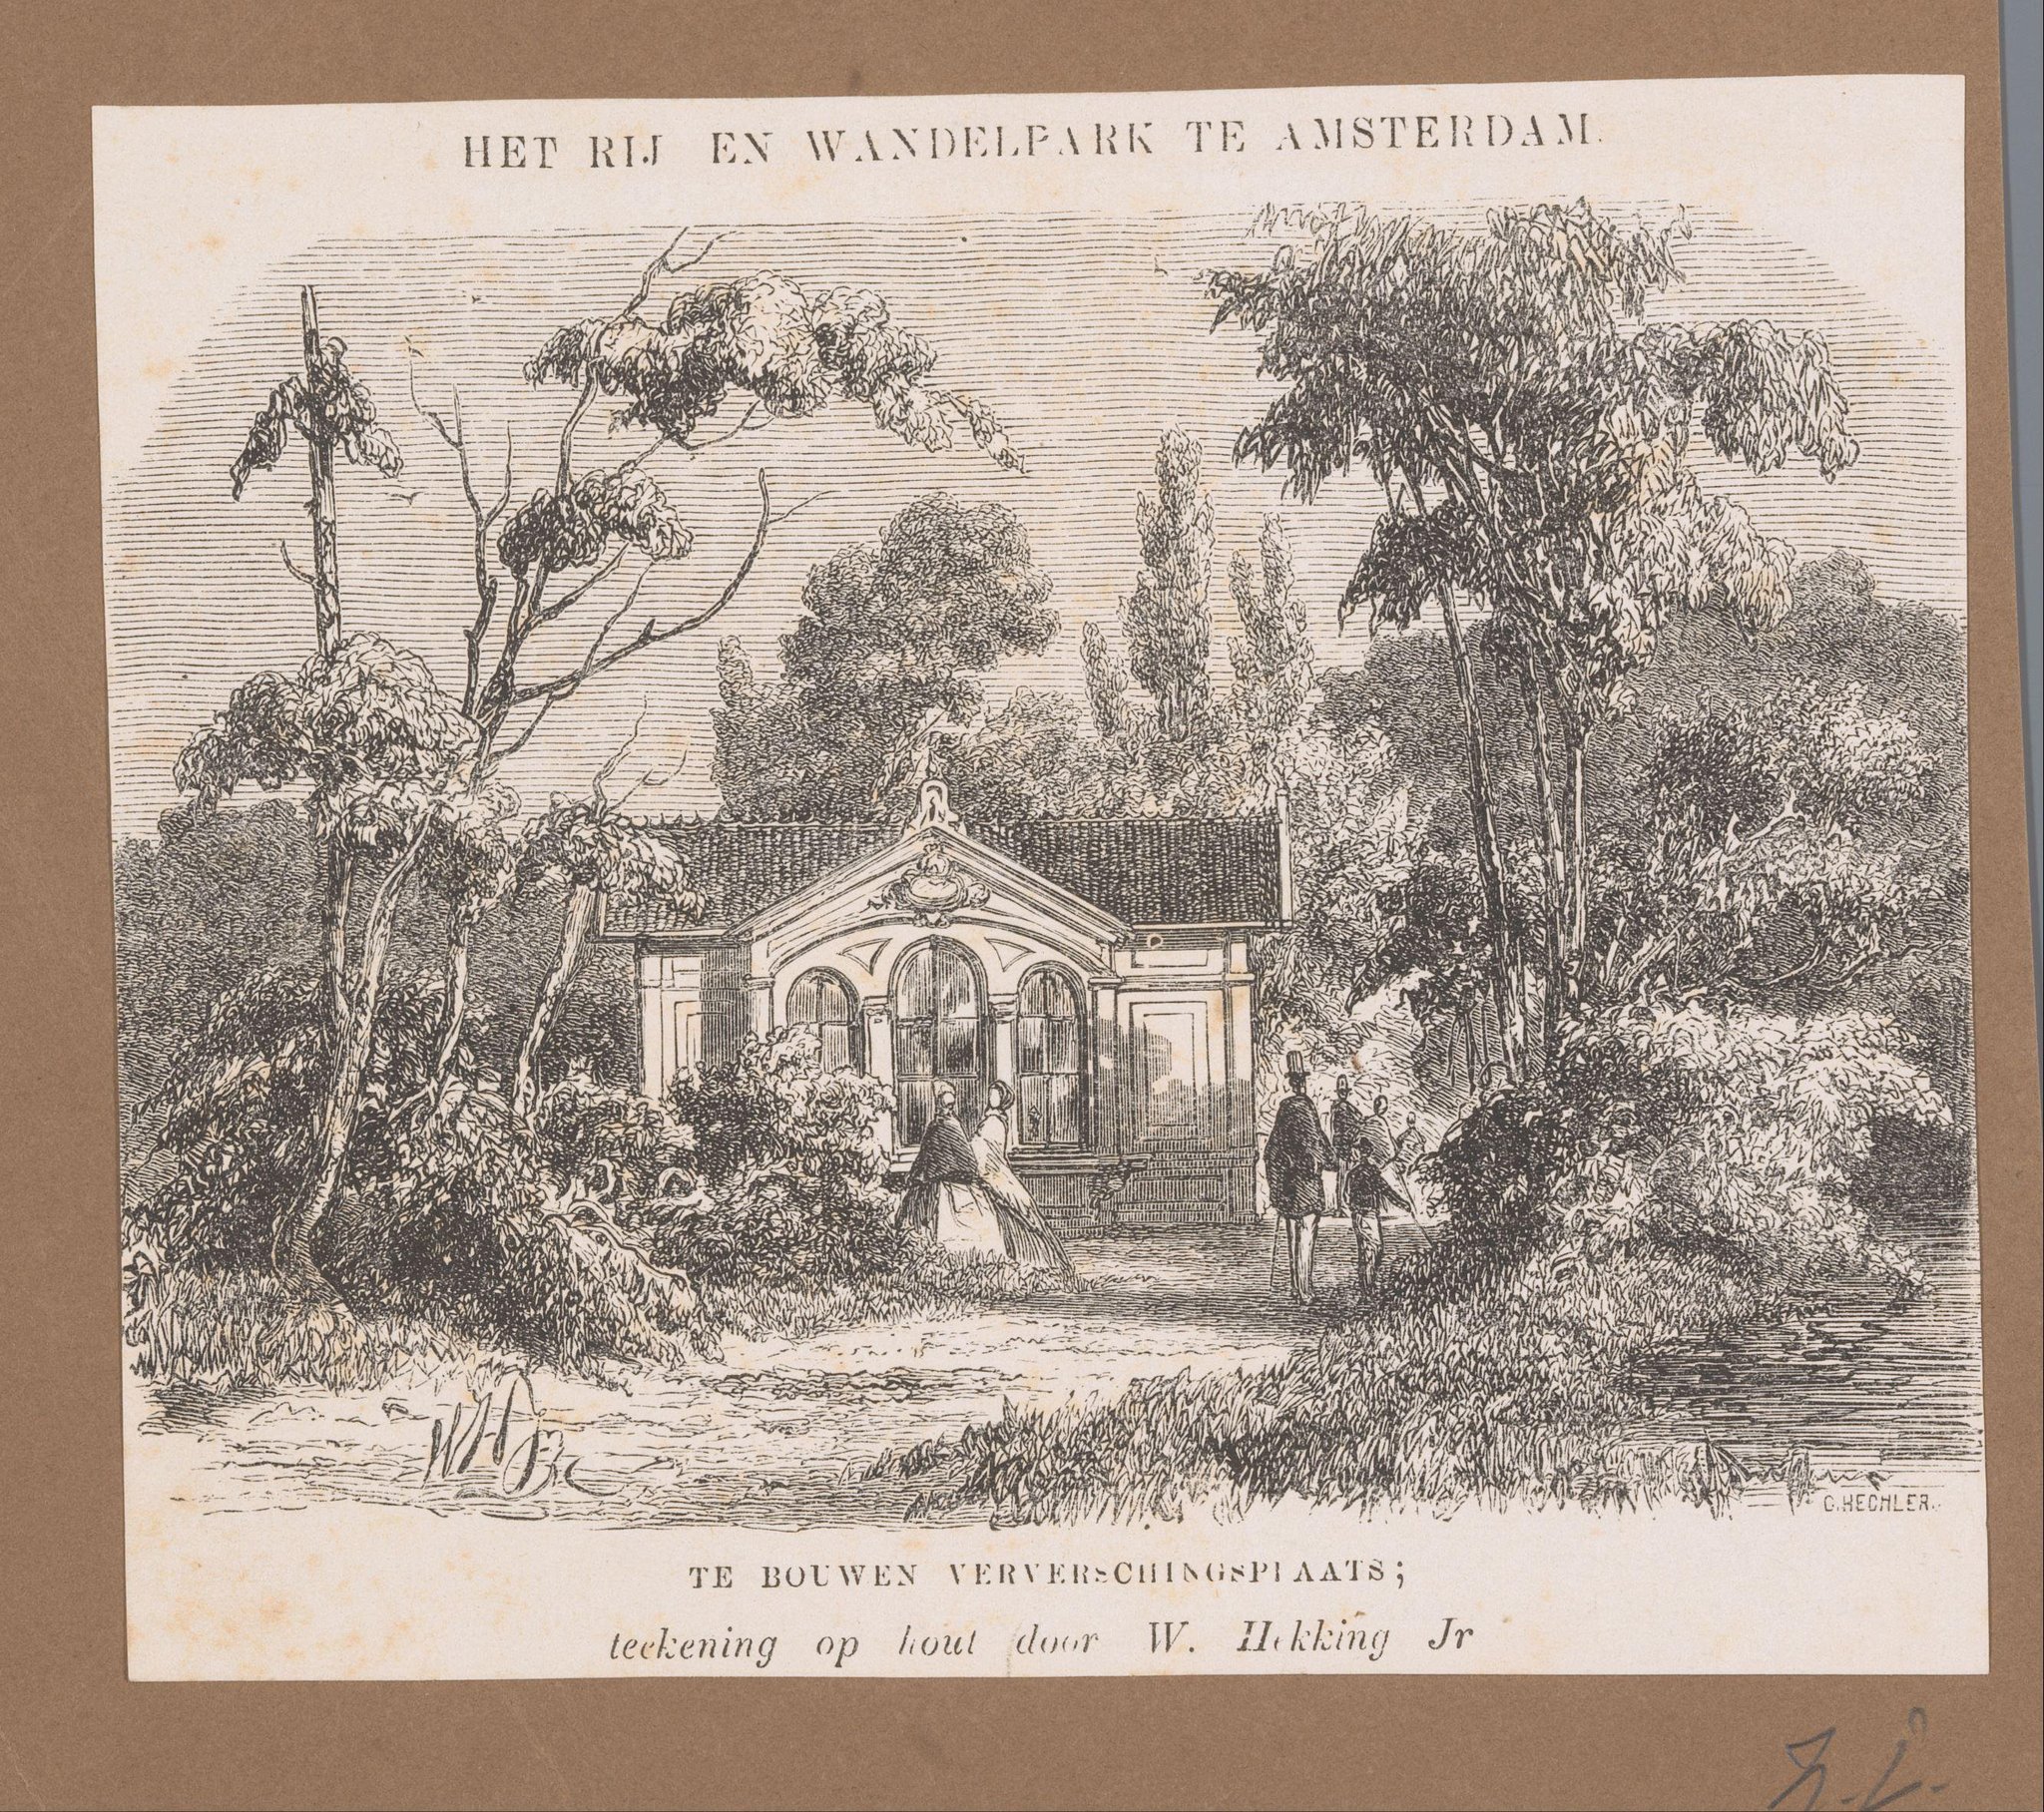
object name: print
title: Te bouwen ververschingsplaats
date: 1866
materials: paper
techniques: letterpress printing, engraving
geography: amsterdam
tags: park, hut, cabin, lodge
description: Prent uit: Witkamp, P.H. 'Het Rij en Wandelpark te Amsterdam', Het Nederlandsch Magazijn (1866), nr. 10, p. 73.